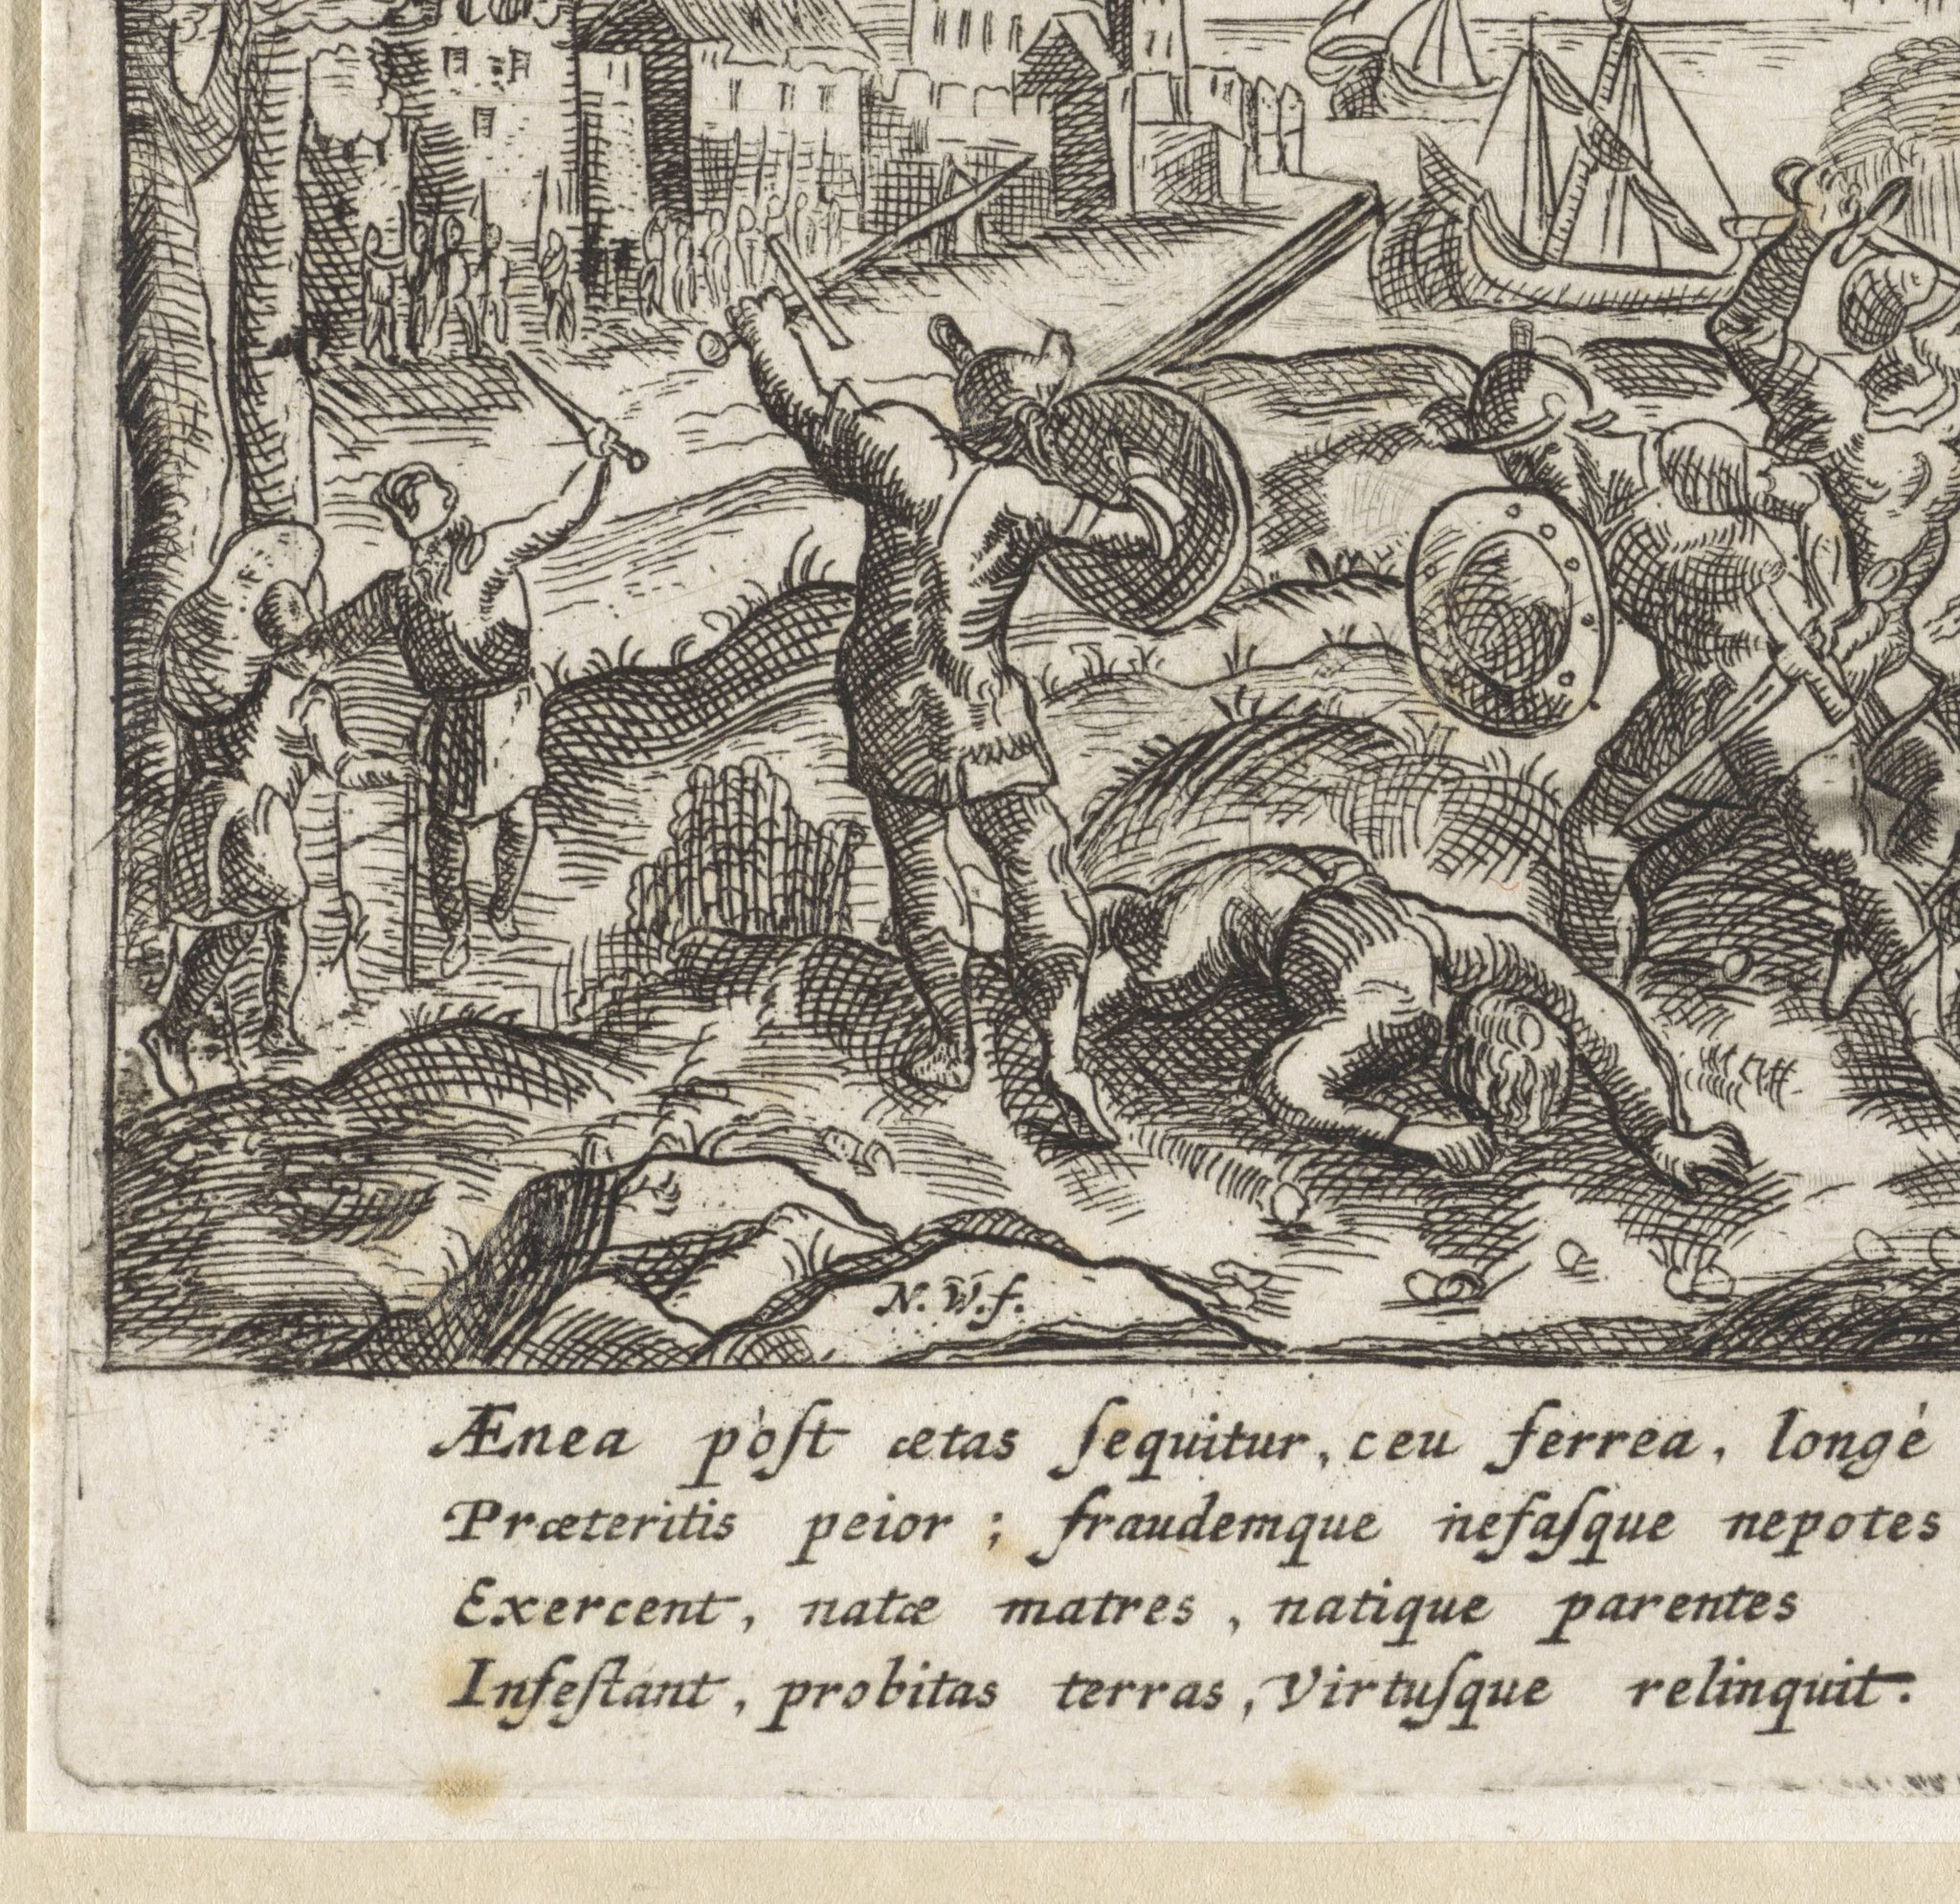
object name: print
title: Scènes uit het eerste boek van Ovidius' Metamorphosen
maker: nicolaes cornelisz. witsen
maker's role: mayor, print maker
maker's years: 1641-1717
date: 1659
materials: paper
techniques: etching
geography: amsterdam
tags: the iron age, 'aetas ferrea'; characterized by mars, war and rapine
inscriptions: collector's mark: Lugt 2165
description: Verbeelding van het leven tijdens de IJzeren Eeuw. Soldaten plunderen en voeren oorlog. Onder de voorstelling een vierregelige toelichting in het Latijn.